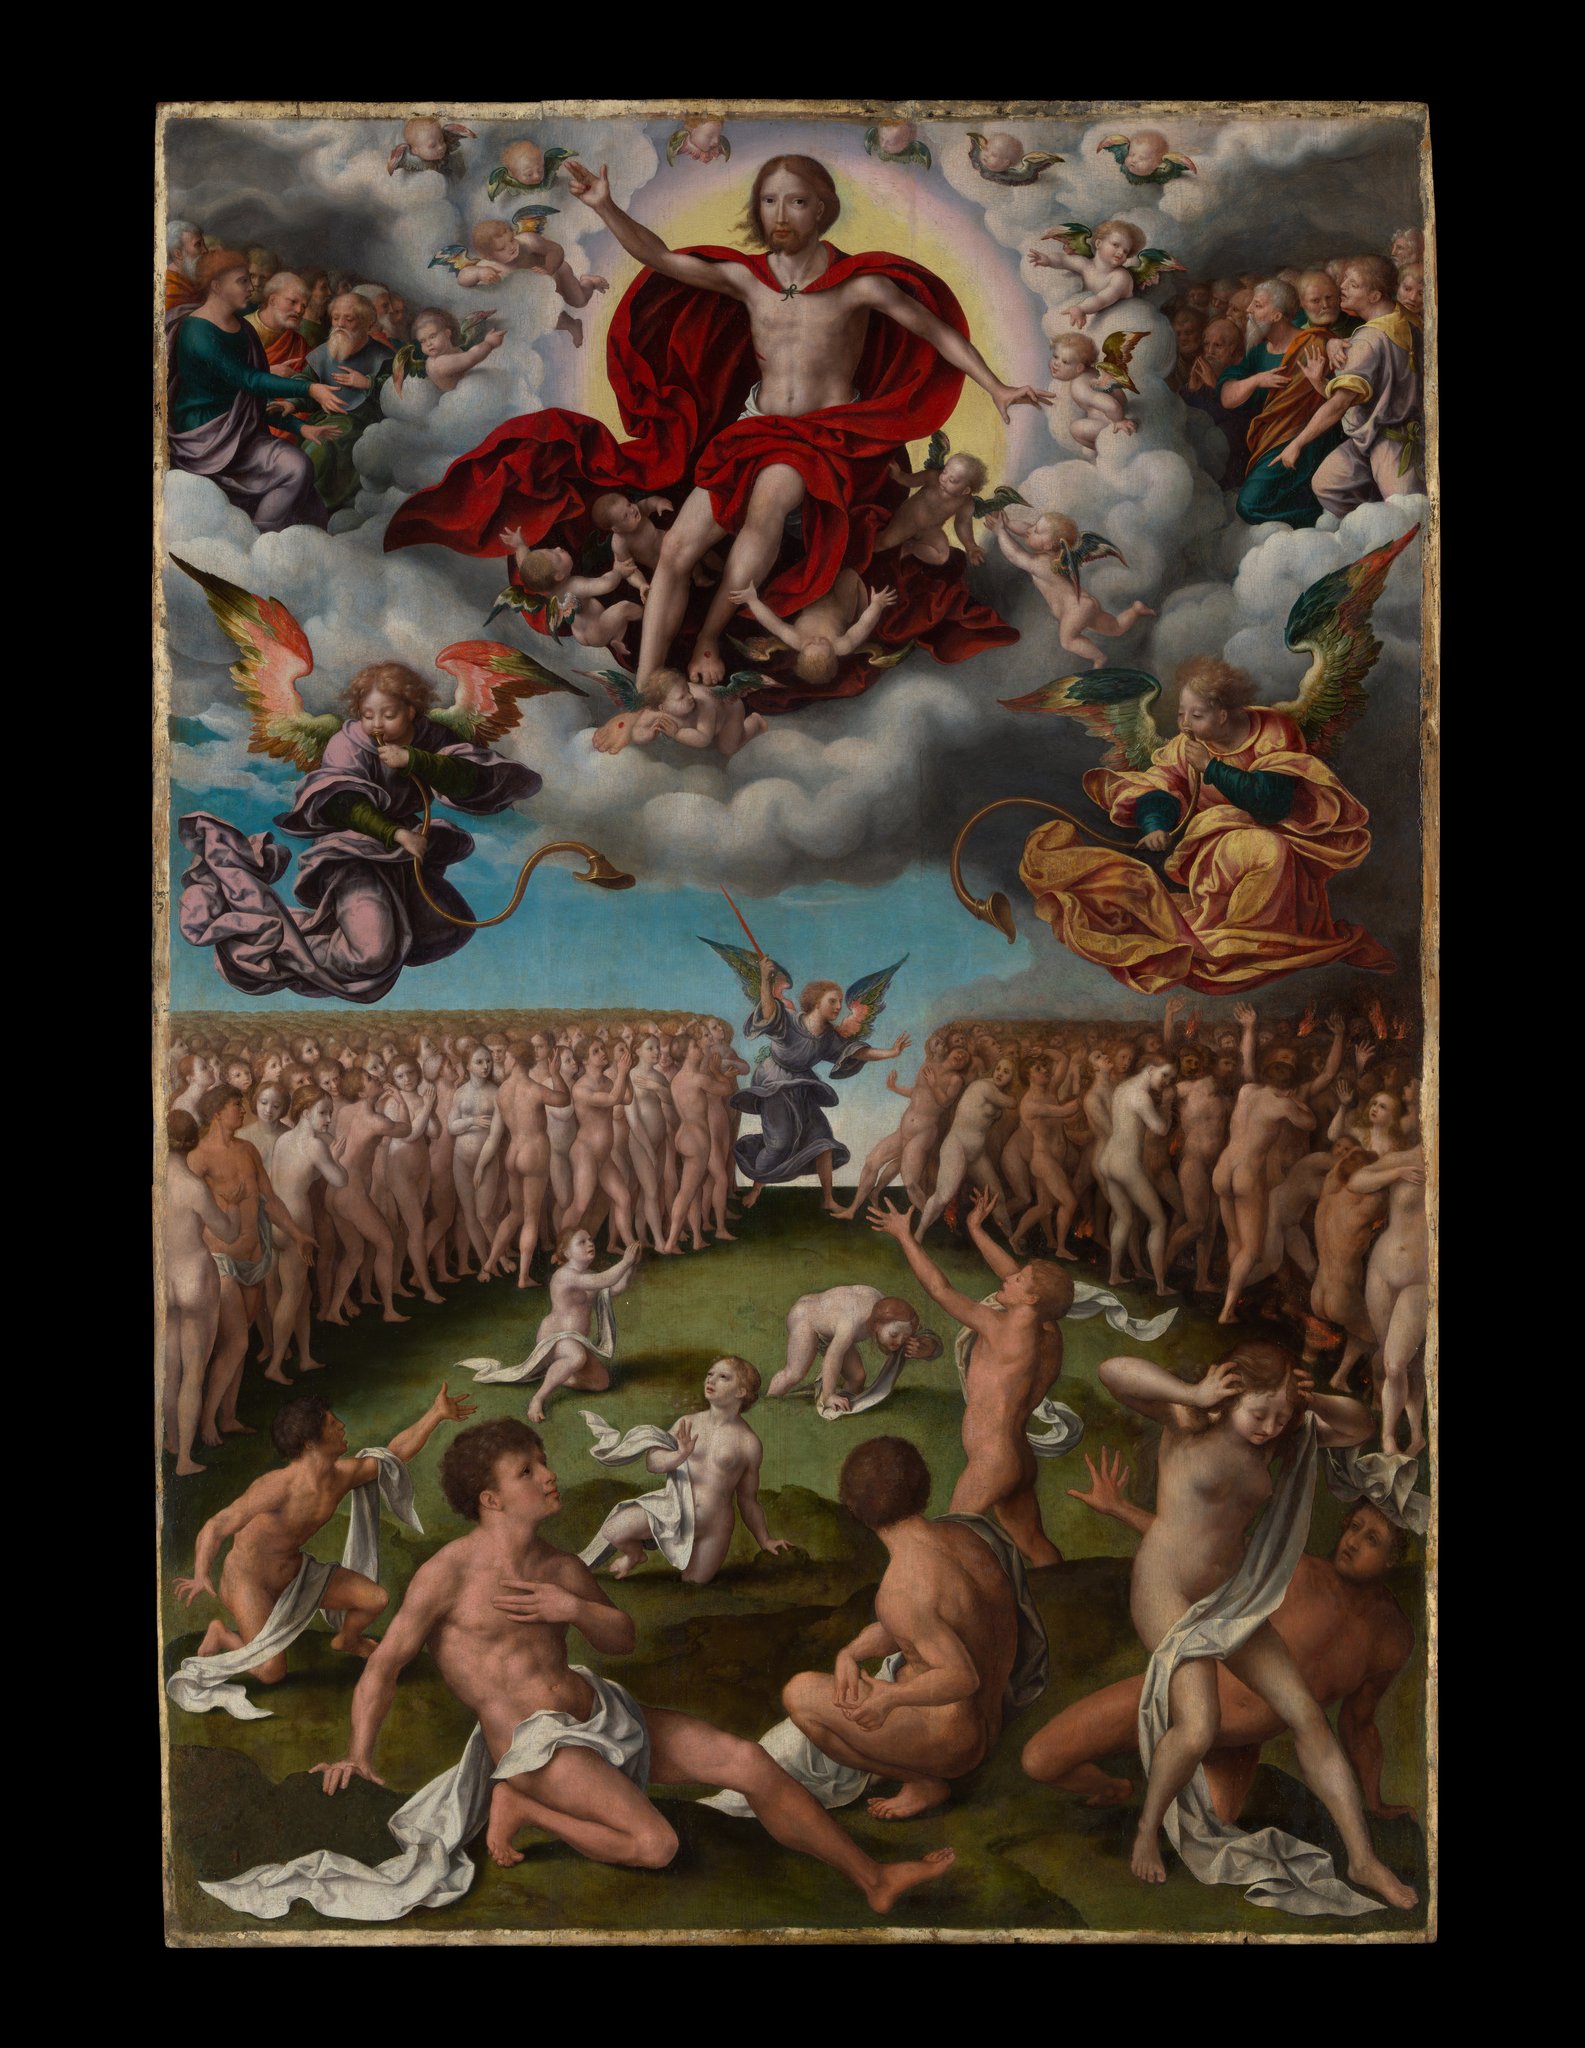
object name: painting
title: The Last Judgment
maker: joos van cleve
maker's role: artist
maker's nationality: netherlandish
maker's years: 1485-1541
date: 1525-1530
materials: oil, wood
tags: male nudes,female nudes,putti,angels,christ,last judgement